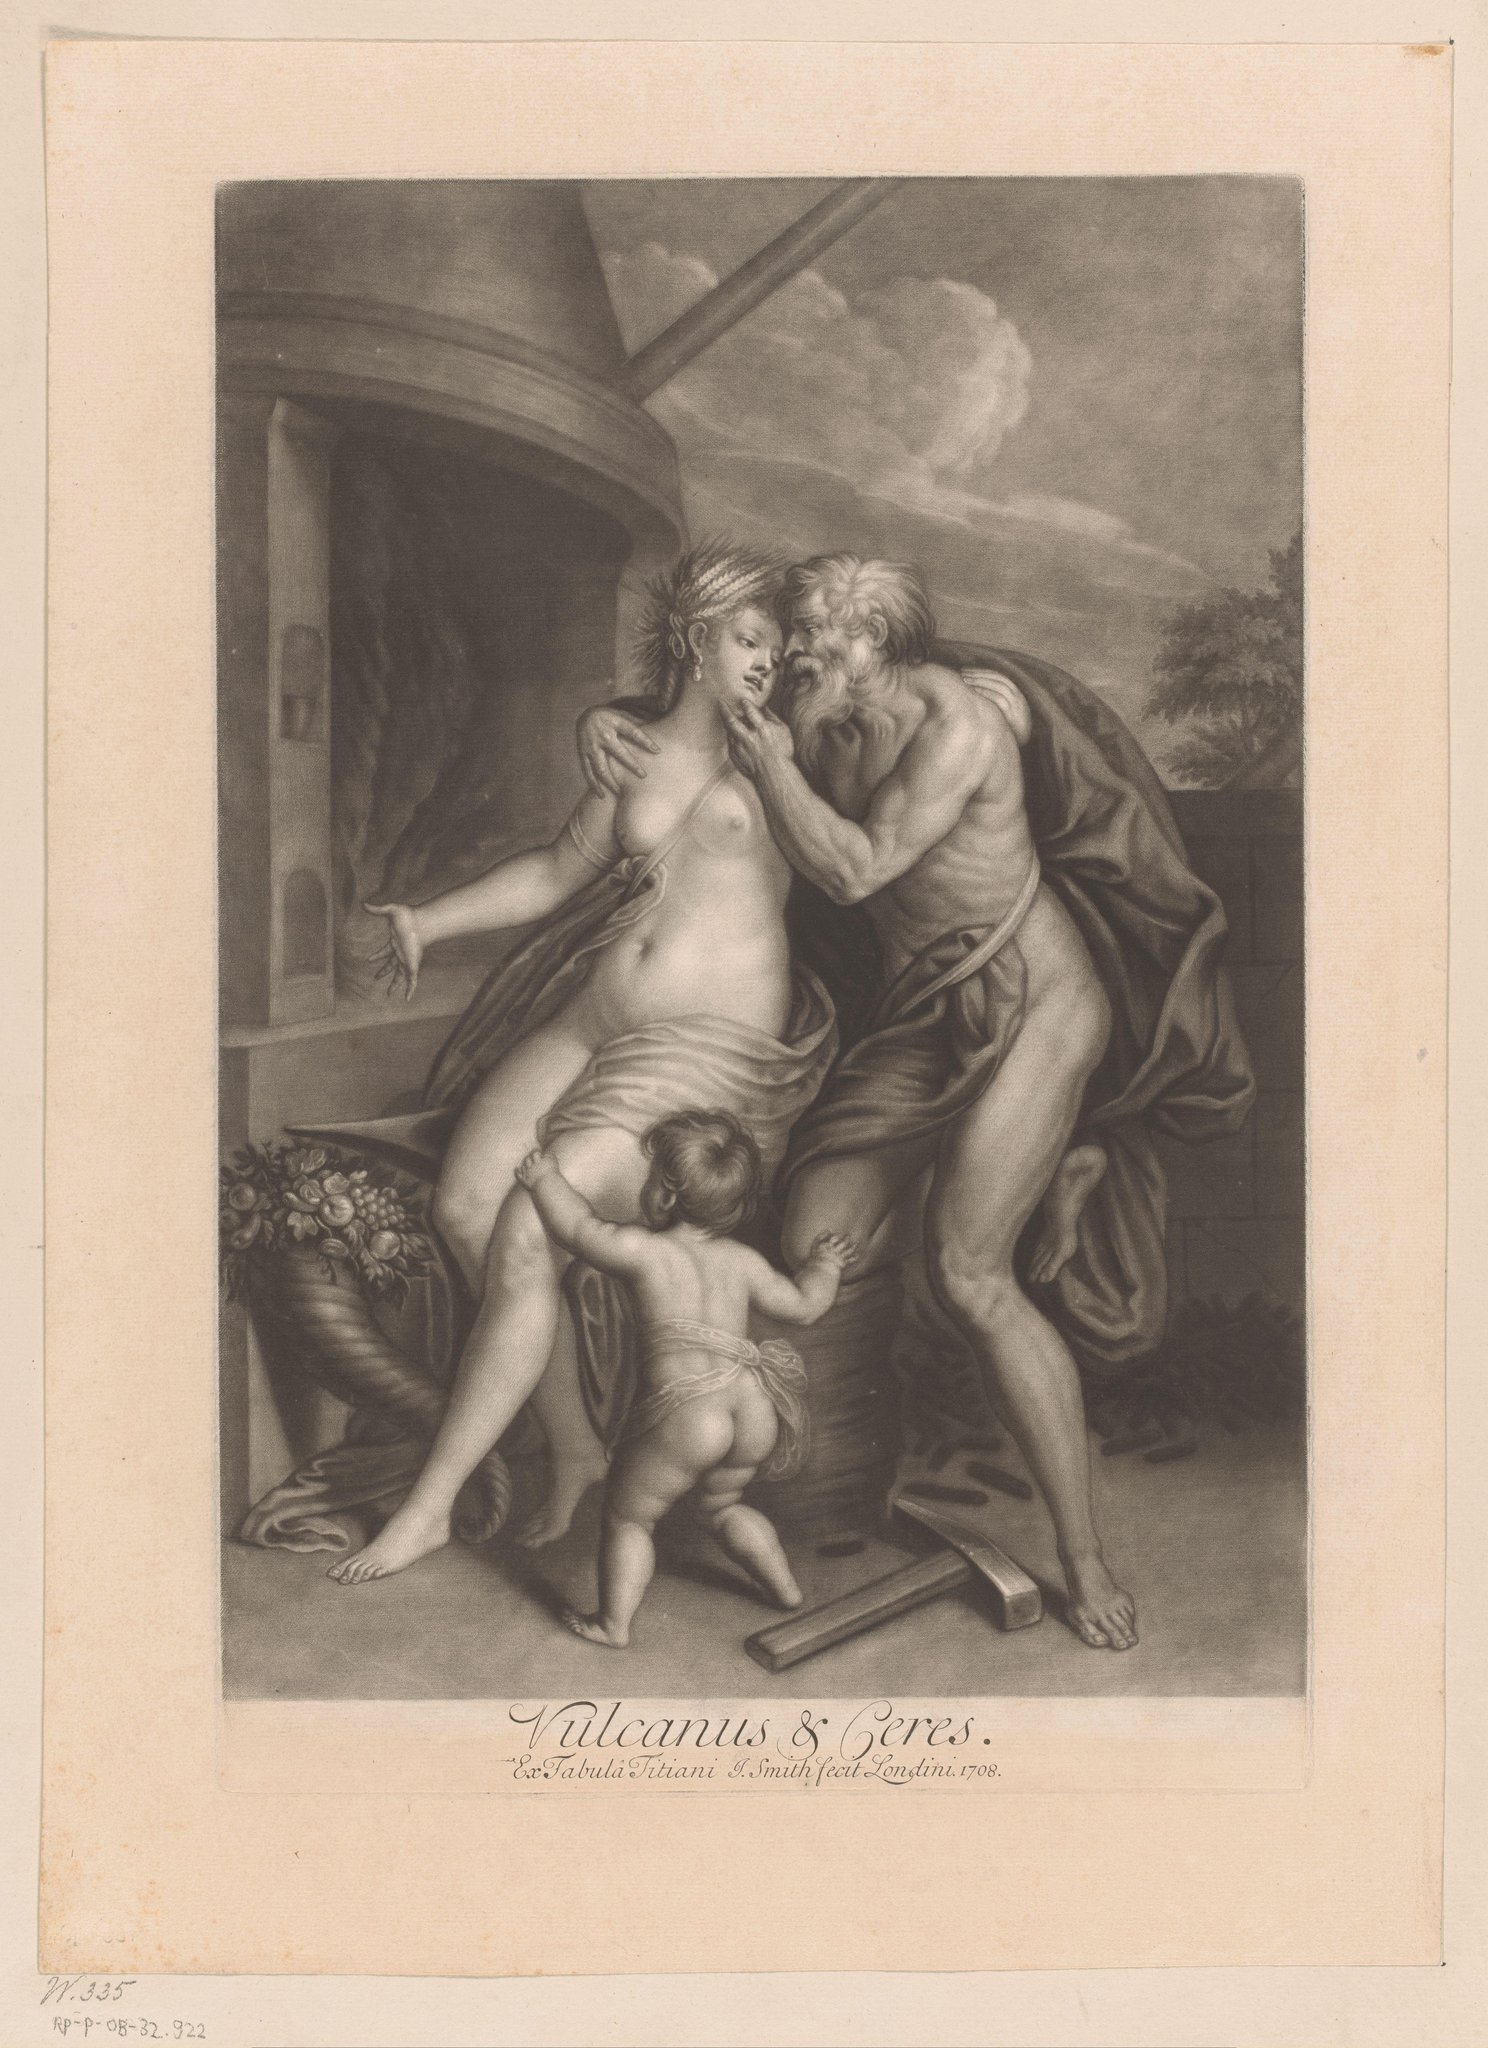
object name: print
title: Loves of the gods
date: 1708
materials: paper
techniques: mezzotint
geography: london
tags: (story of) vulcan (hephaestus), couple of lovers, love-affairs of ceres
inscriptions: date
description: Prent maakt deel uit van een serie van negen prenten.